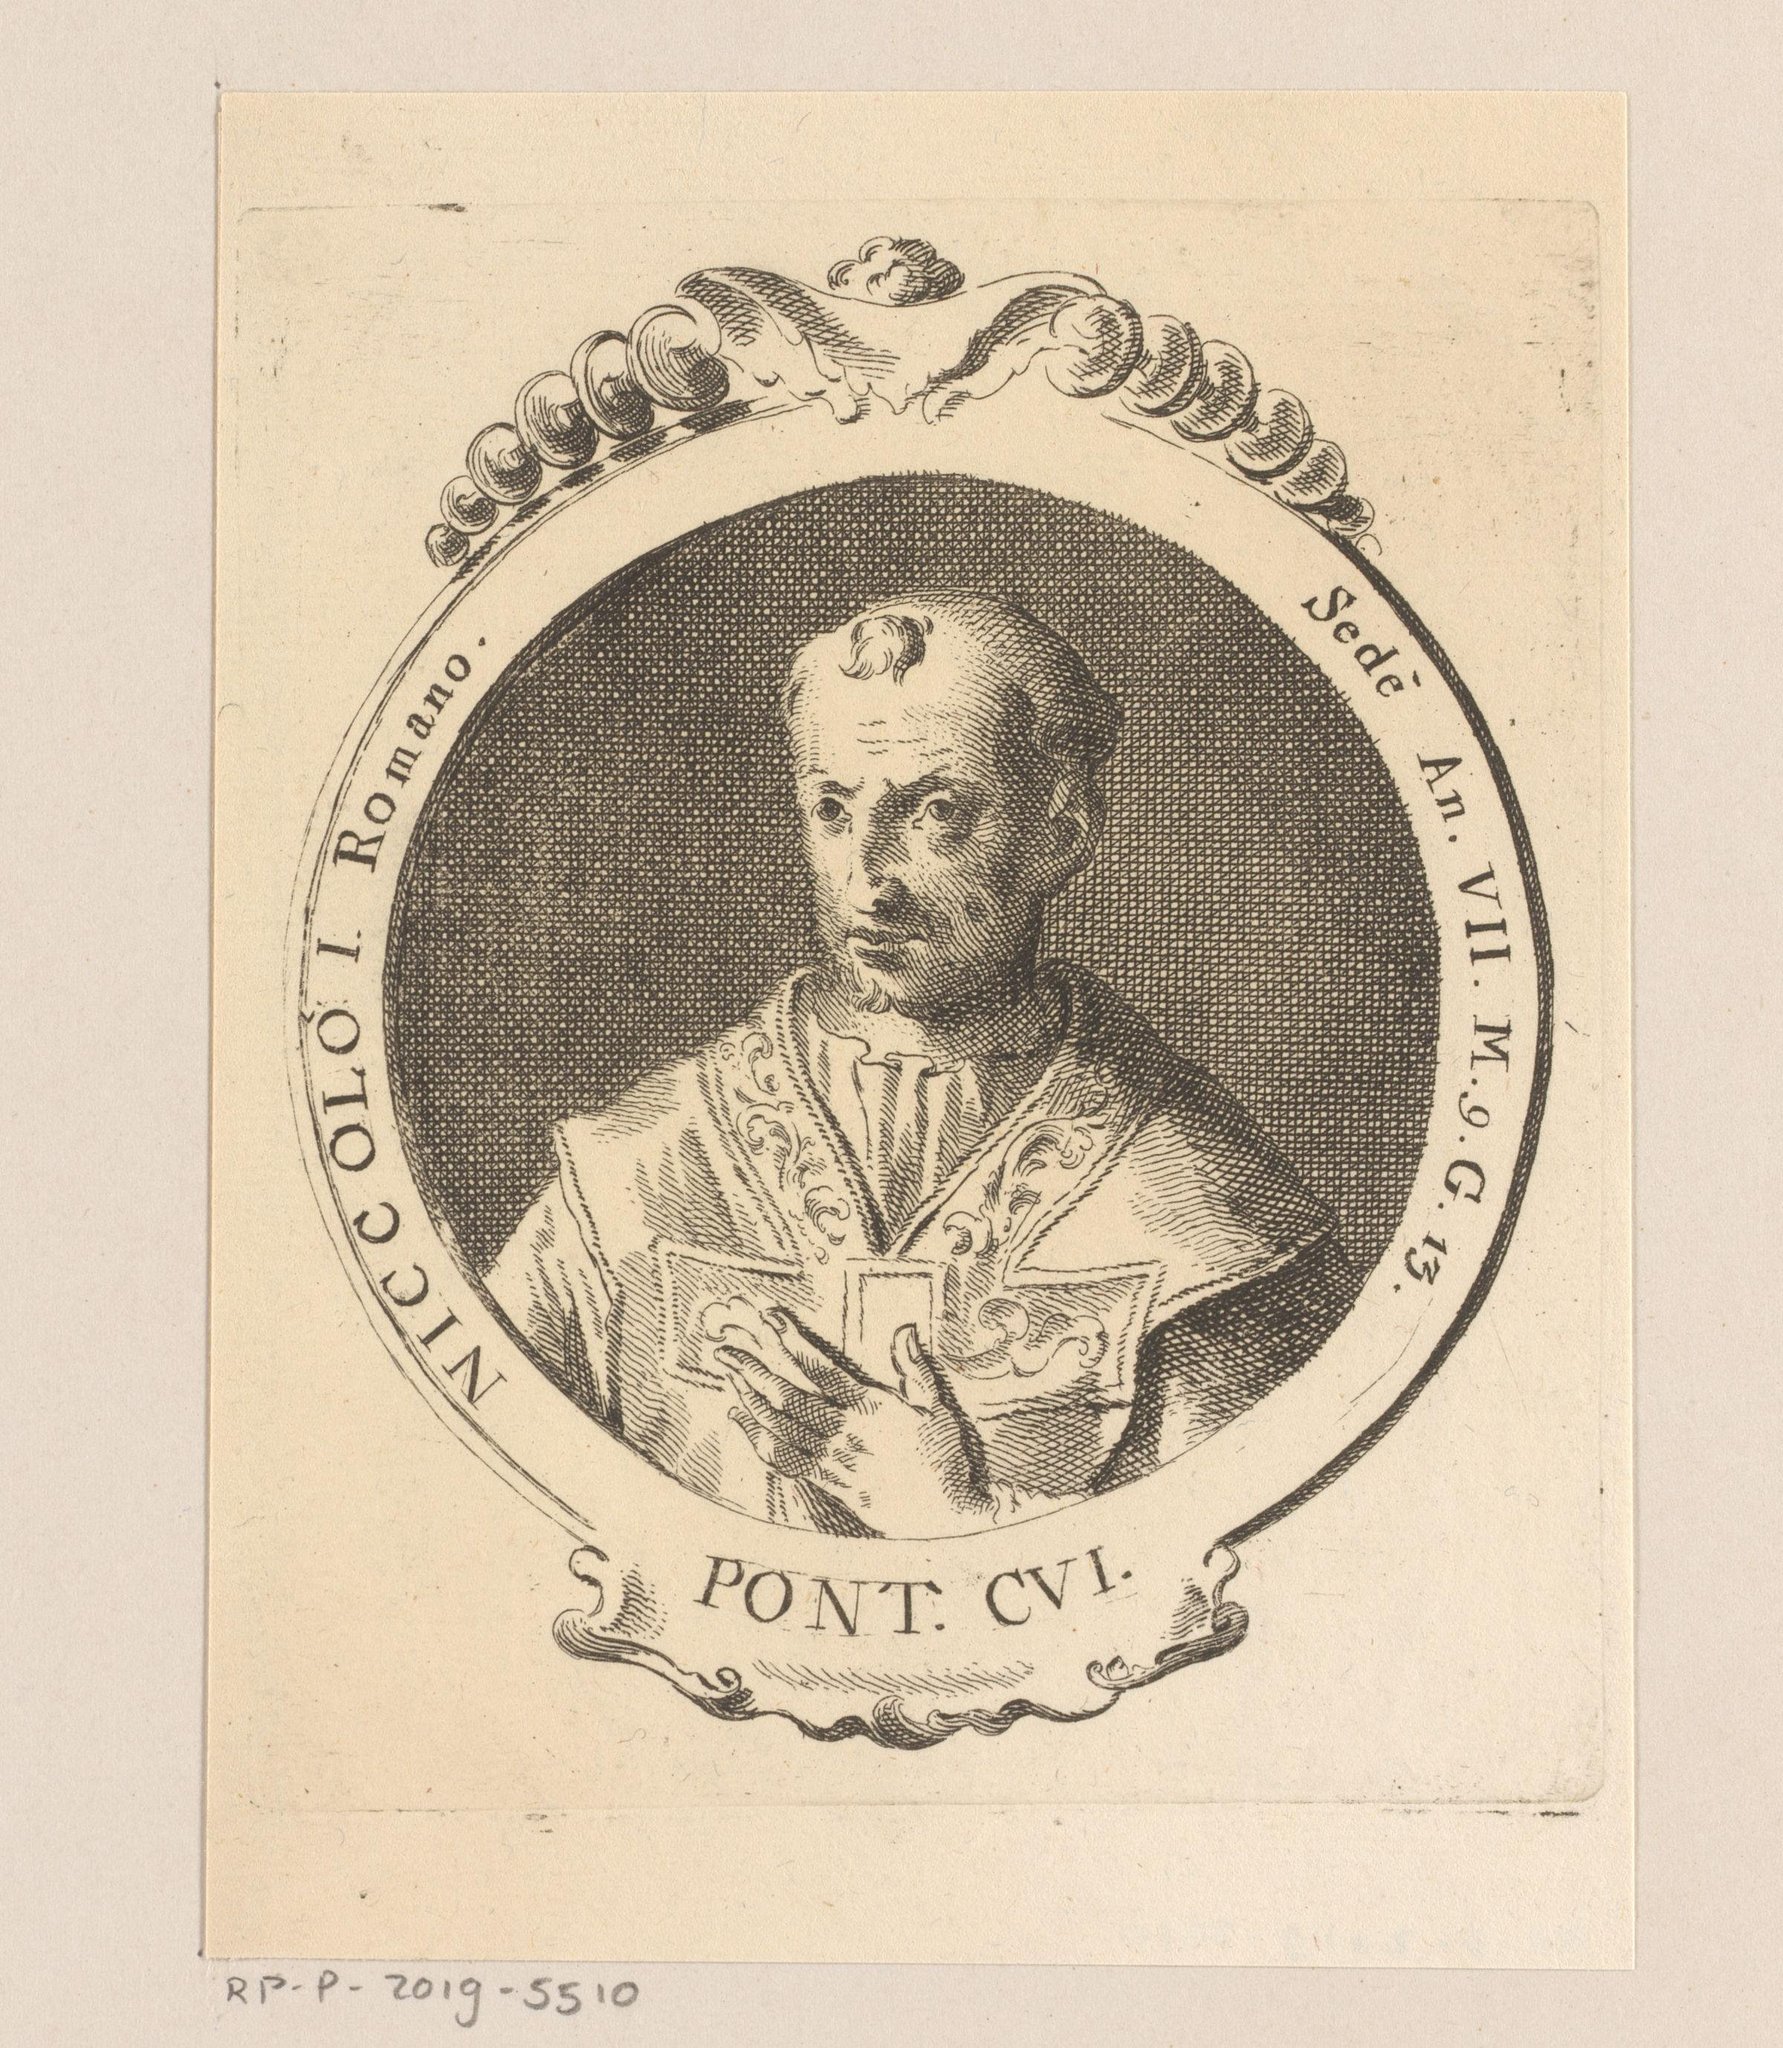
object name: book illustration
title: Portret van paus Nicolaas I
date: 1775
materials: paper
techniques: etching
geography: bassano del grappa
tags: rome, historical persons, pope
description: Prent uit: Effigies Romanorum pontificum a S. Petro ad Pium VI. feliciter regnantem (...). 2 dln. Venetië en Bassano del Grappa: Giuseppe Remondini, 1775.